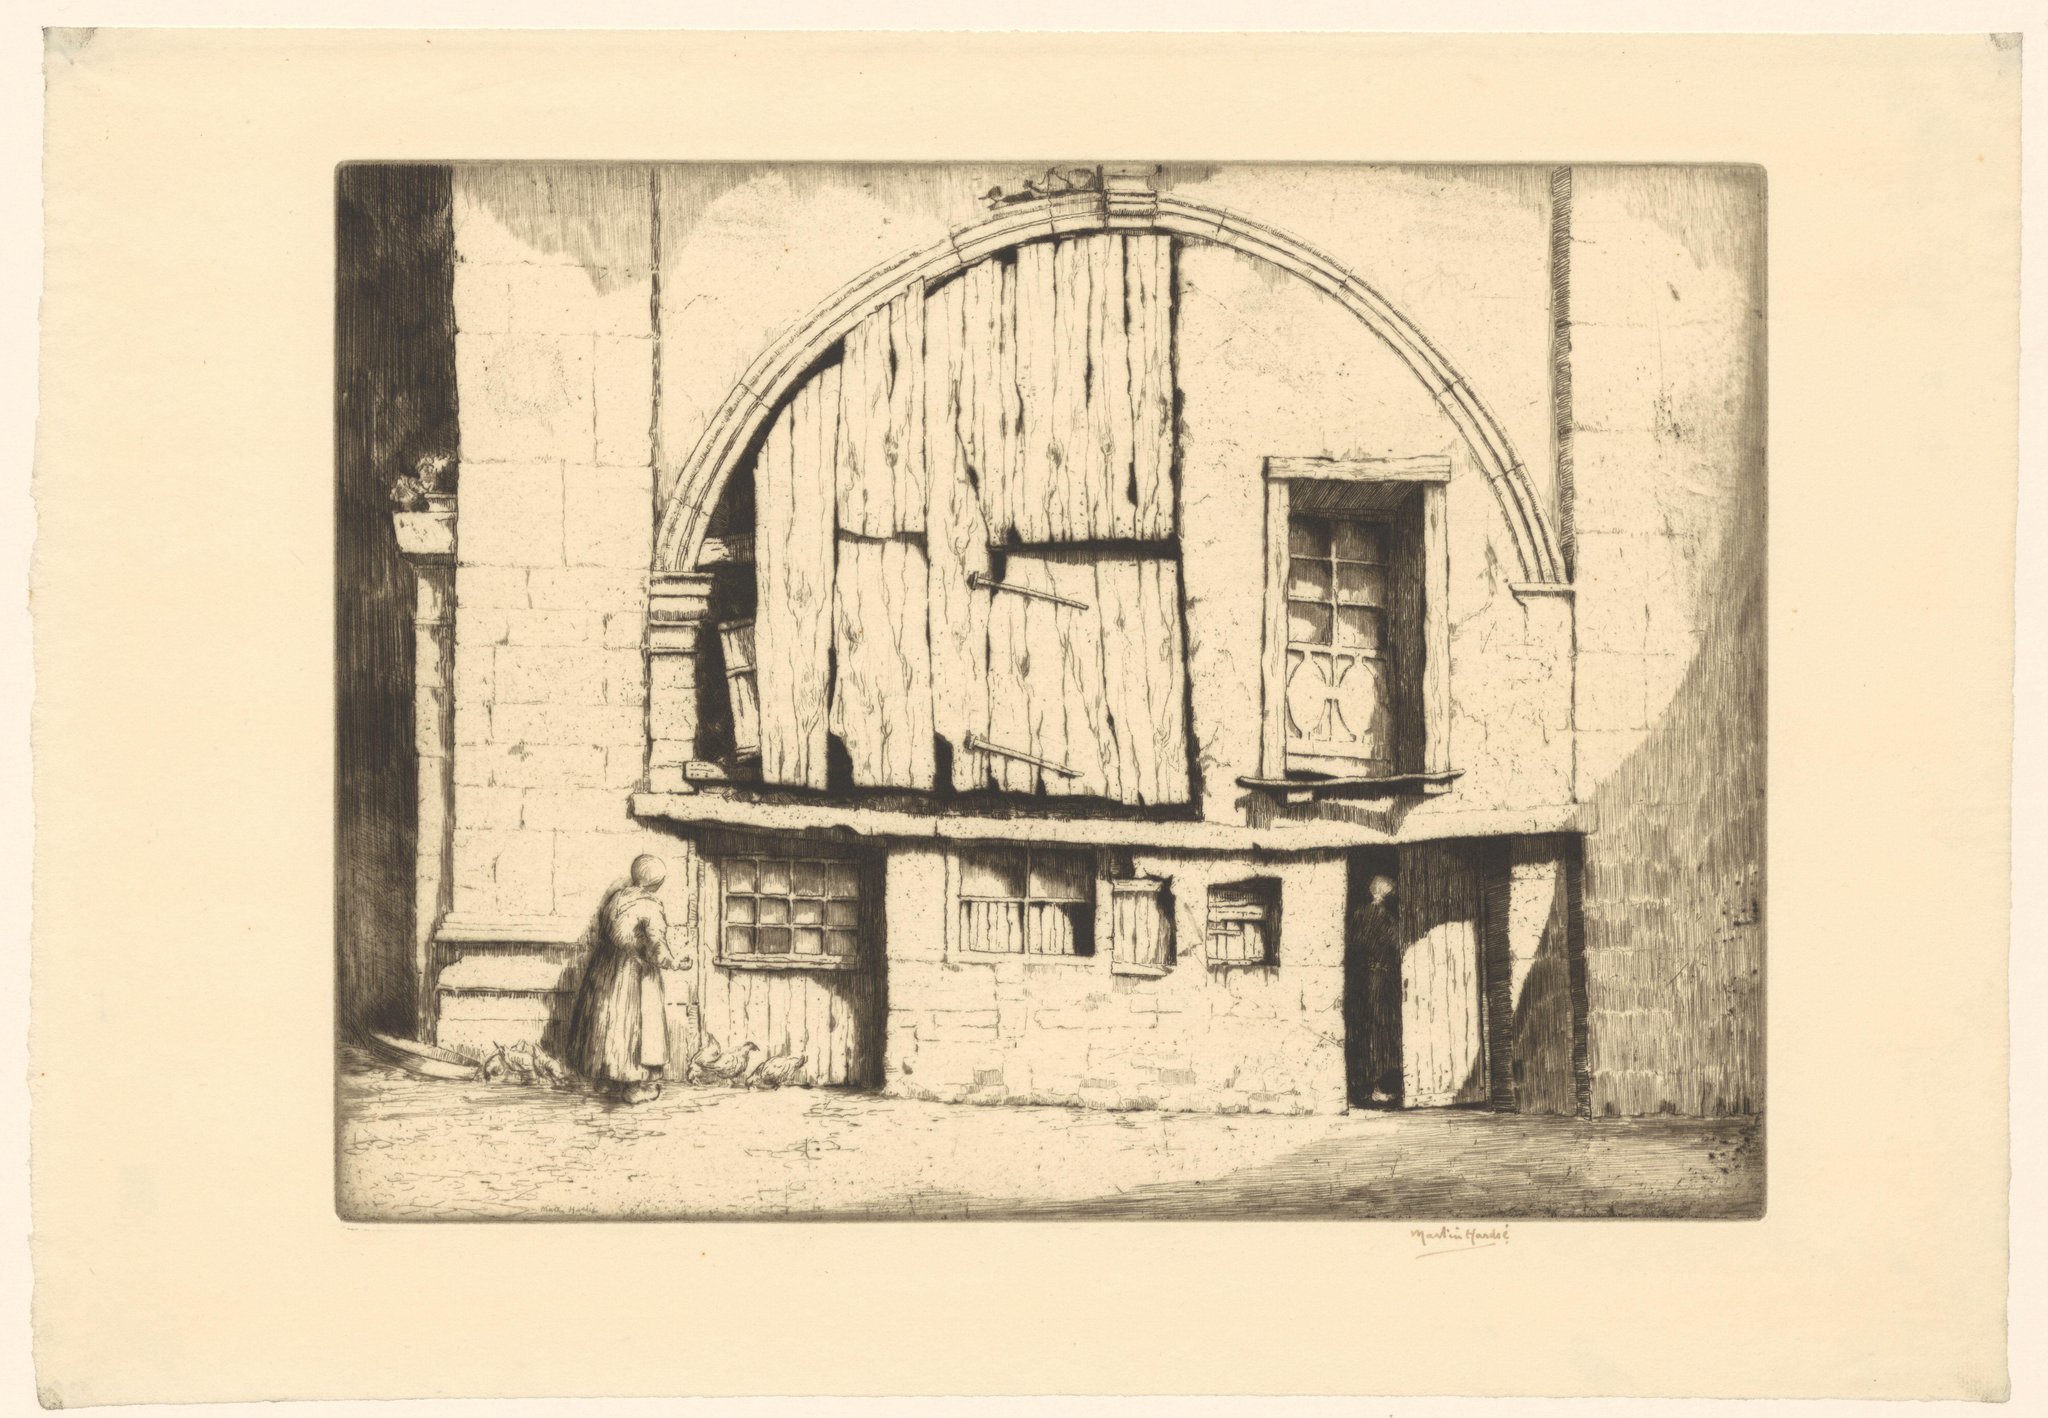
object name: print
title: Verlaten klooster in Mouthier-Haute-Pierre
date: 1930-1931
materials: paper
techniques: drypoint, etching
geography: mouthier-haute-pierre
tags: farmers - aa - female farmer, farmer's wife, ruin of church, monastery, etc.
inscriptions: annotation: ‘Martin Hardie’, collector's mark: Lugt 2228, collector's mark: Lugt 2760